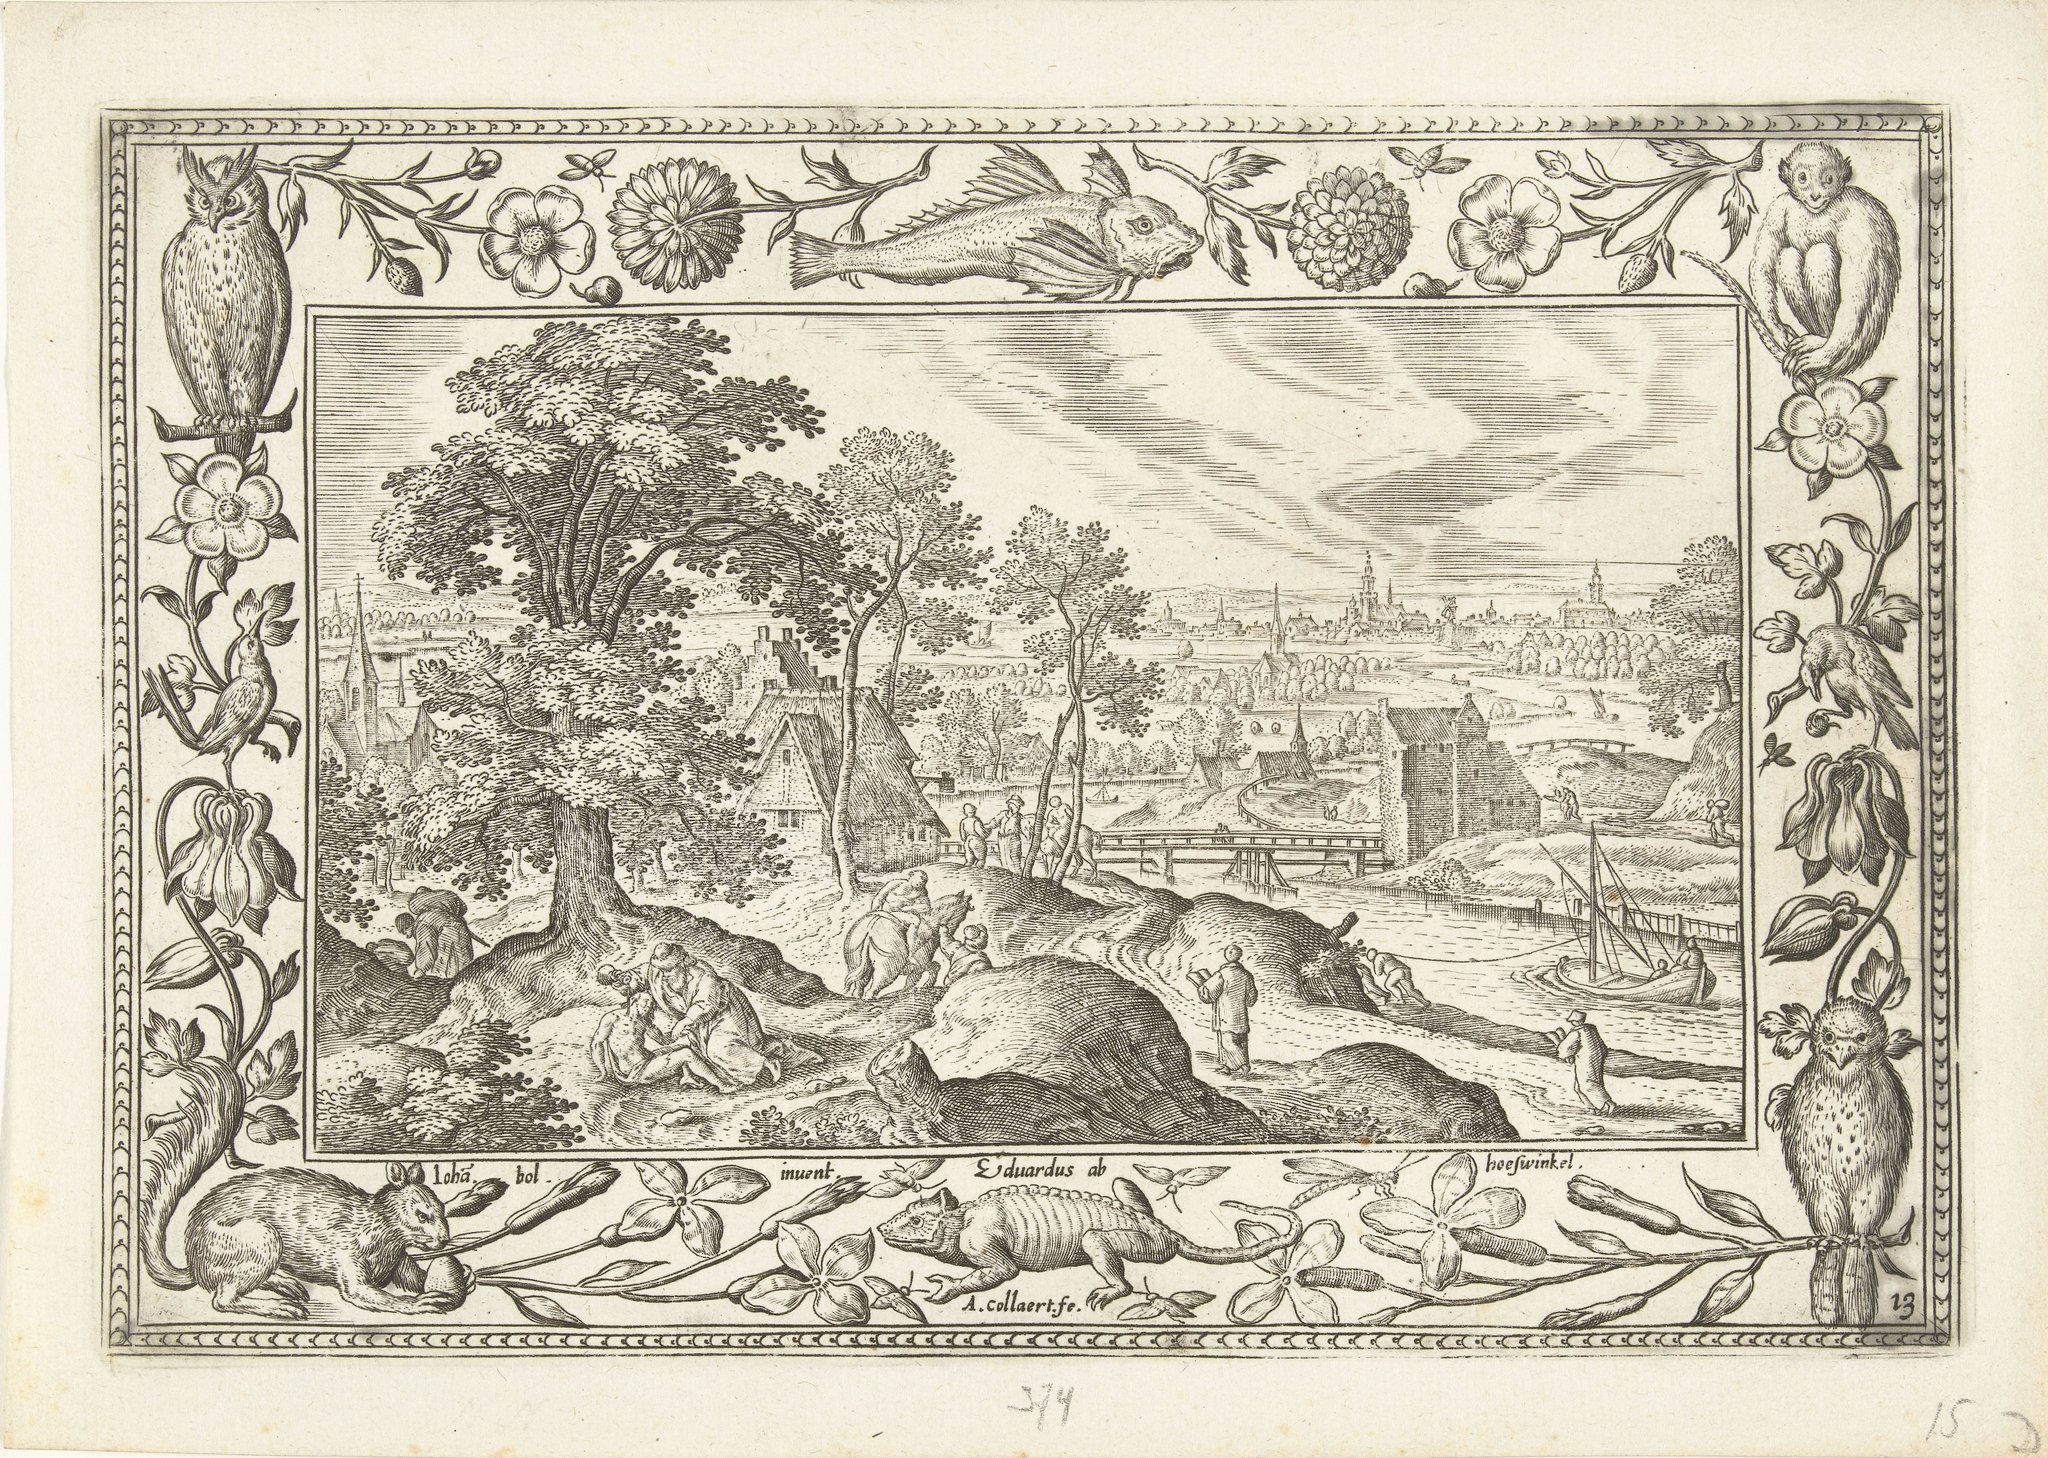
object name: print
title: Parabel van Barmhartige Samaritaan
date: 1582-1586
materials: paper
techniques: engraving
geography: antwerp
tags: river bank, the samaritan and the wounded traveller arrive at the inn; the traveller is cared for, the samaritan sets the wounded traveller on his mount (ass or horse), and brings him to an inn, a priest and/or a levite passing by without attending to the wounded man ~ parable of the good samaritan, a samaritan tending the wounds of the traveller, rodents: squirrel (+ ornamental variants of animals), lizards: chameleon (+ ornamental variants of animals)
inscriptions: collector's mark: Lugt 2228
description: Rivierlandschap met de uitbeelding van de parabel van de Barmhartige Samaritaan. Op de voorgrond verzorgt de barmhartige Samaritaan de gewonde reiziger. Vervolgens wordt de reiziger op zijn paard geholpen en naar de herberg gebracht. Op de achtergrond de Leviet en de priester die de reiziger aan zijn lot overlieten. De prent heeft een ornamentele lijst met bloemen, vissen en dieren. Hij maakt deel uit van een vierentwintigdelige serie van landschappen met Bijbelse, mythologische scènes en jachttaferelen.